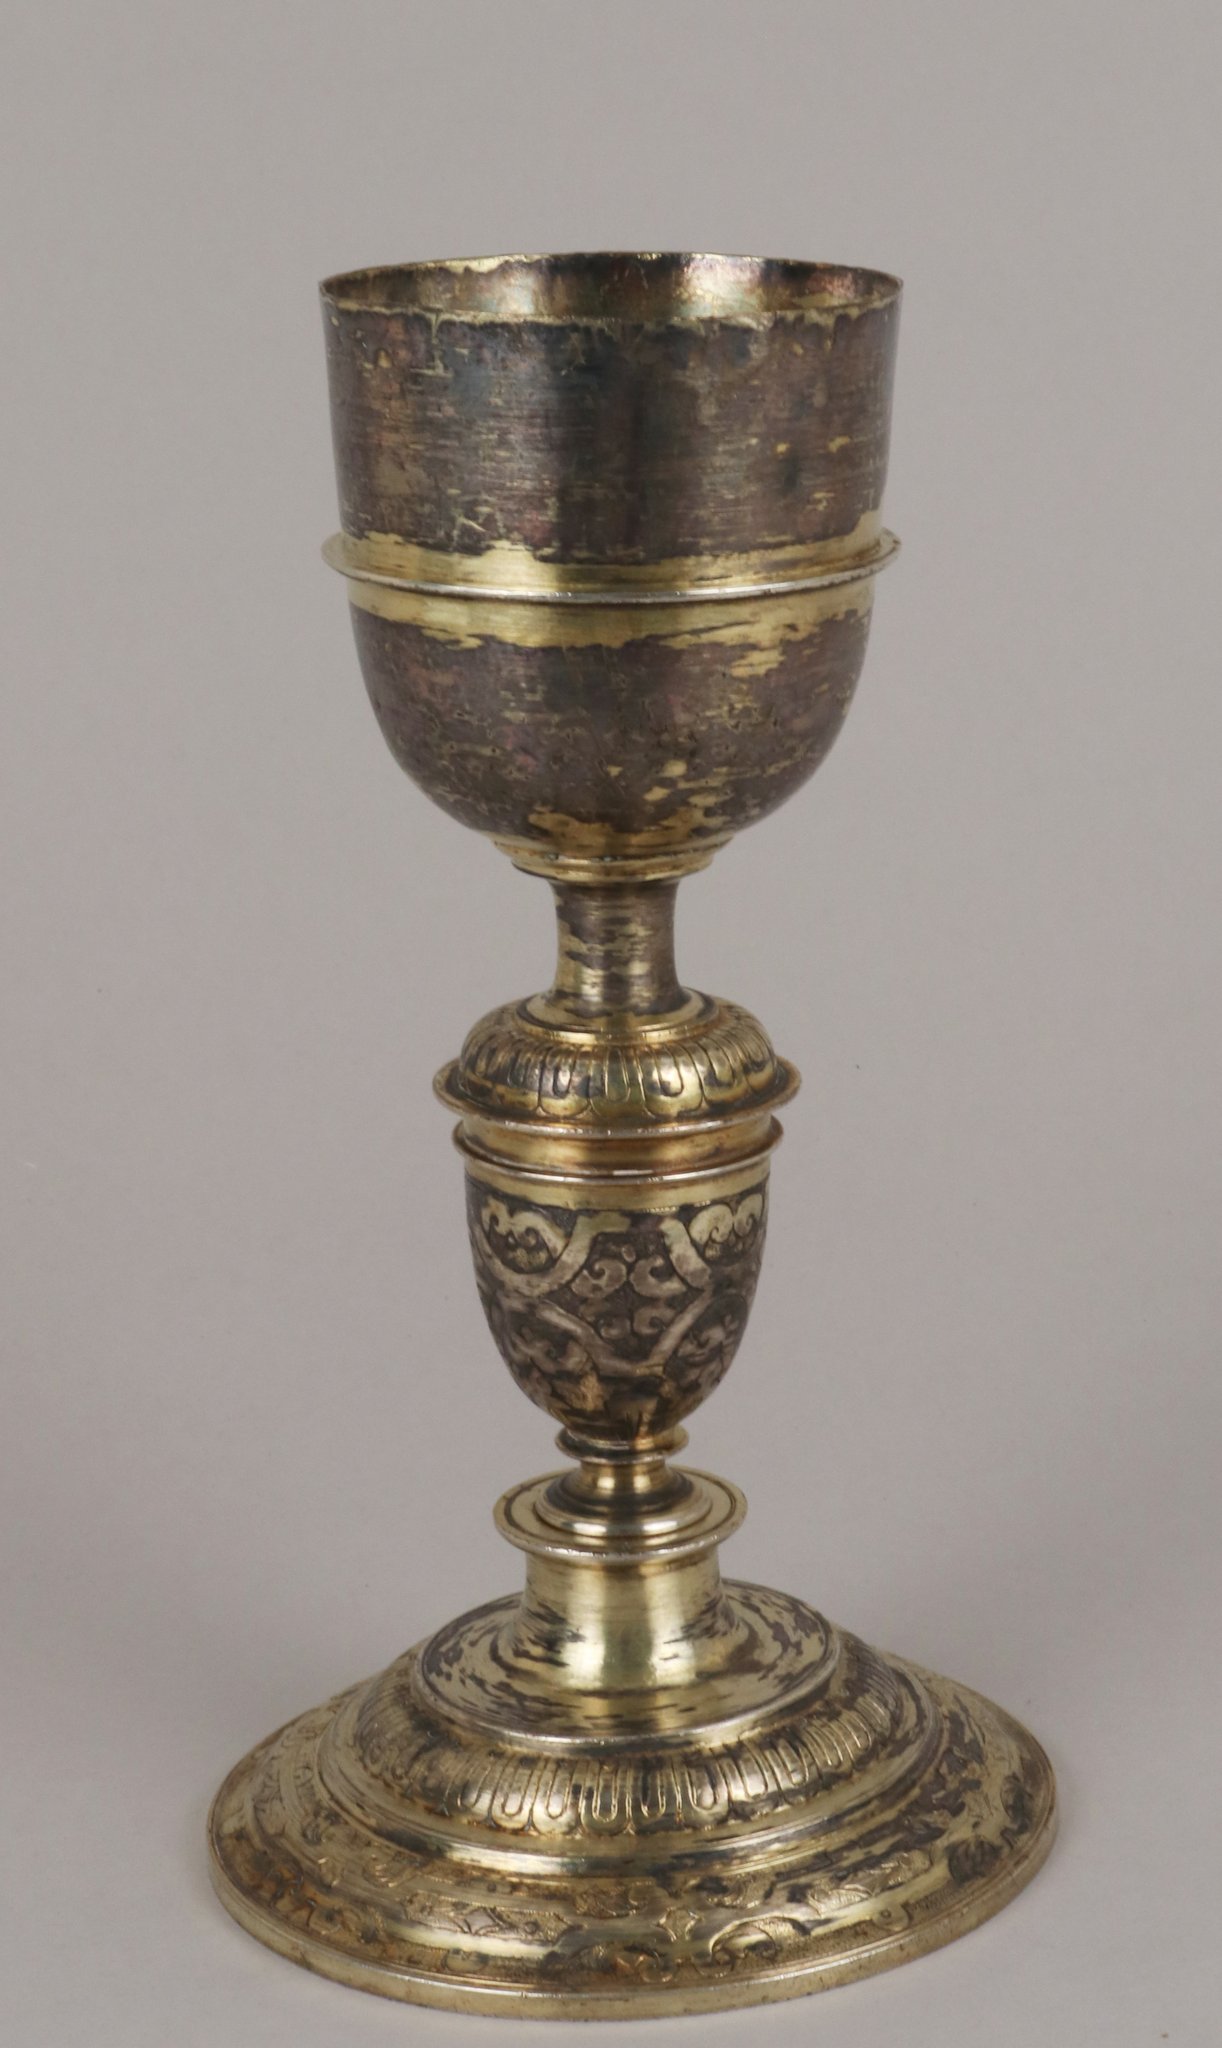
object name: chalice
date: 1601-1700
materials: silver gilt